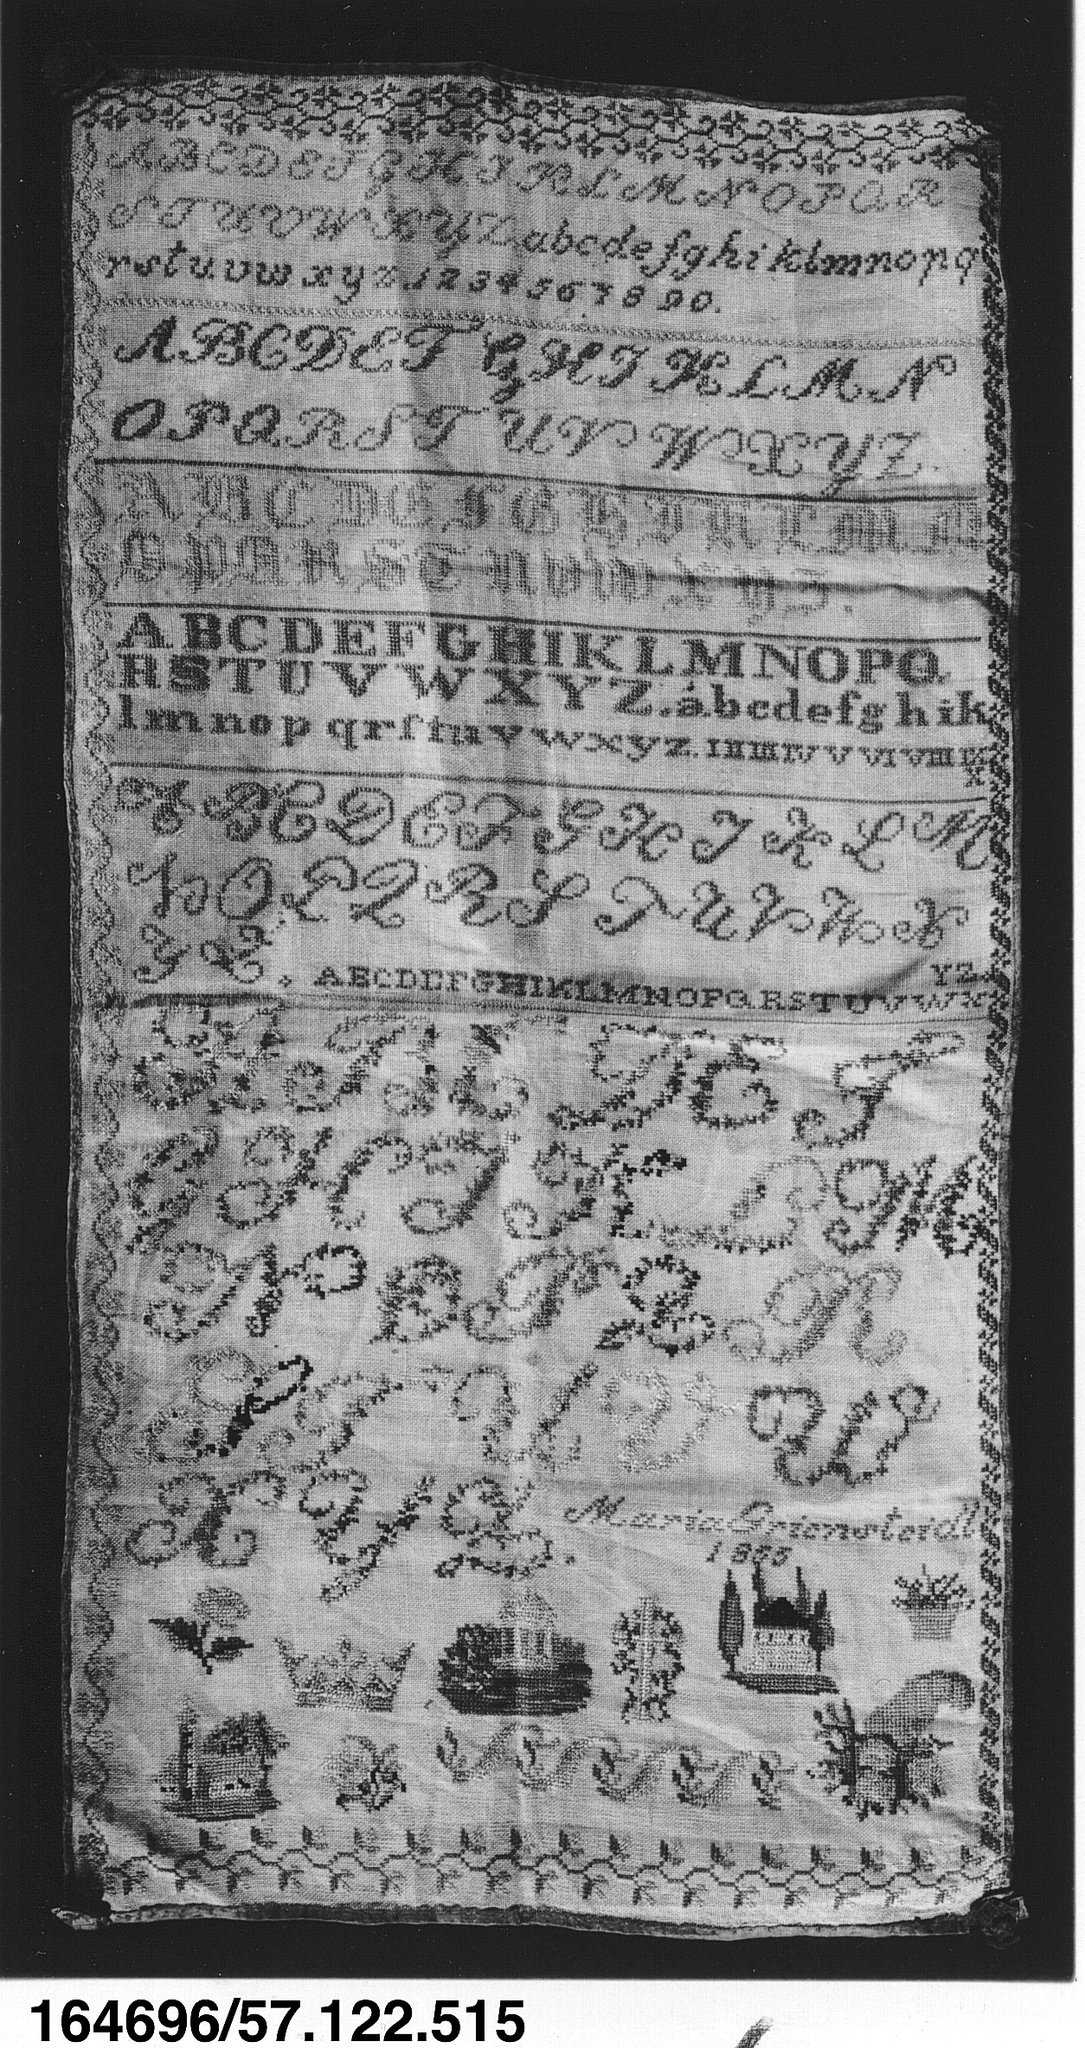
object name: sampler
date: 1855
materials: canvas, cotton, silk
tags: flowers